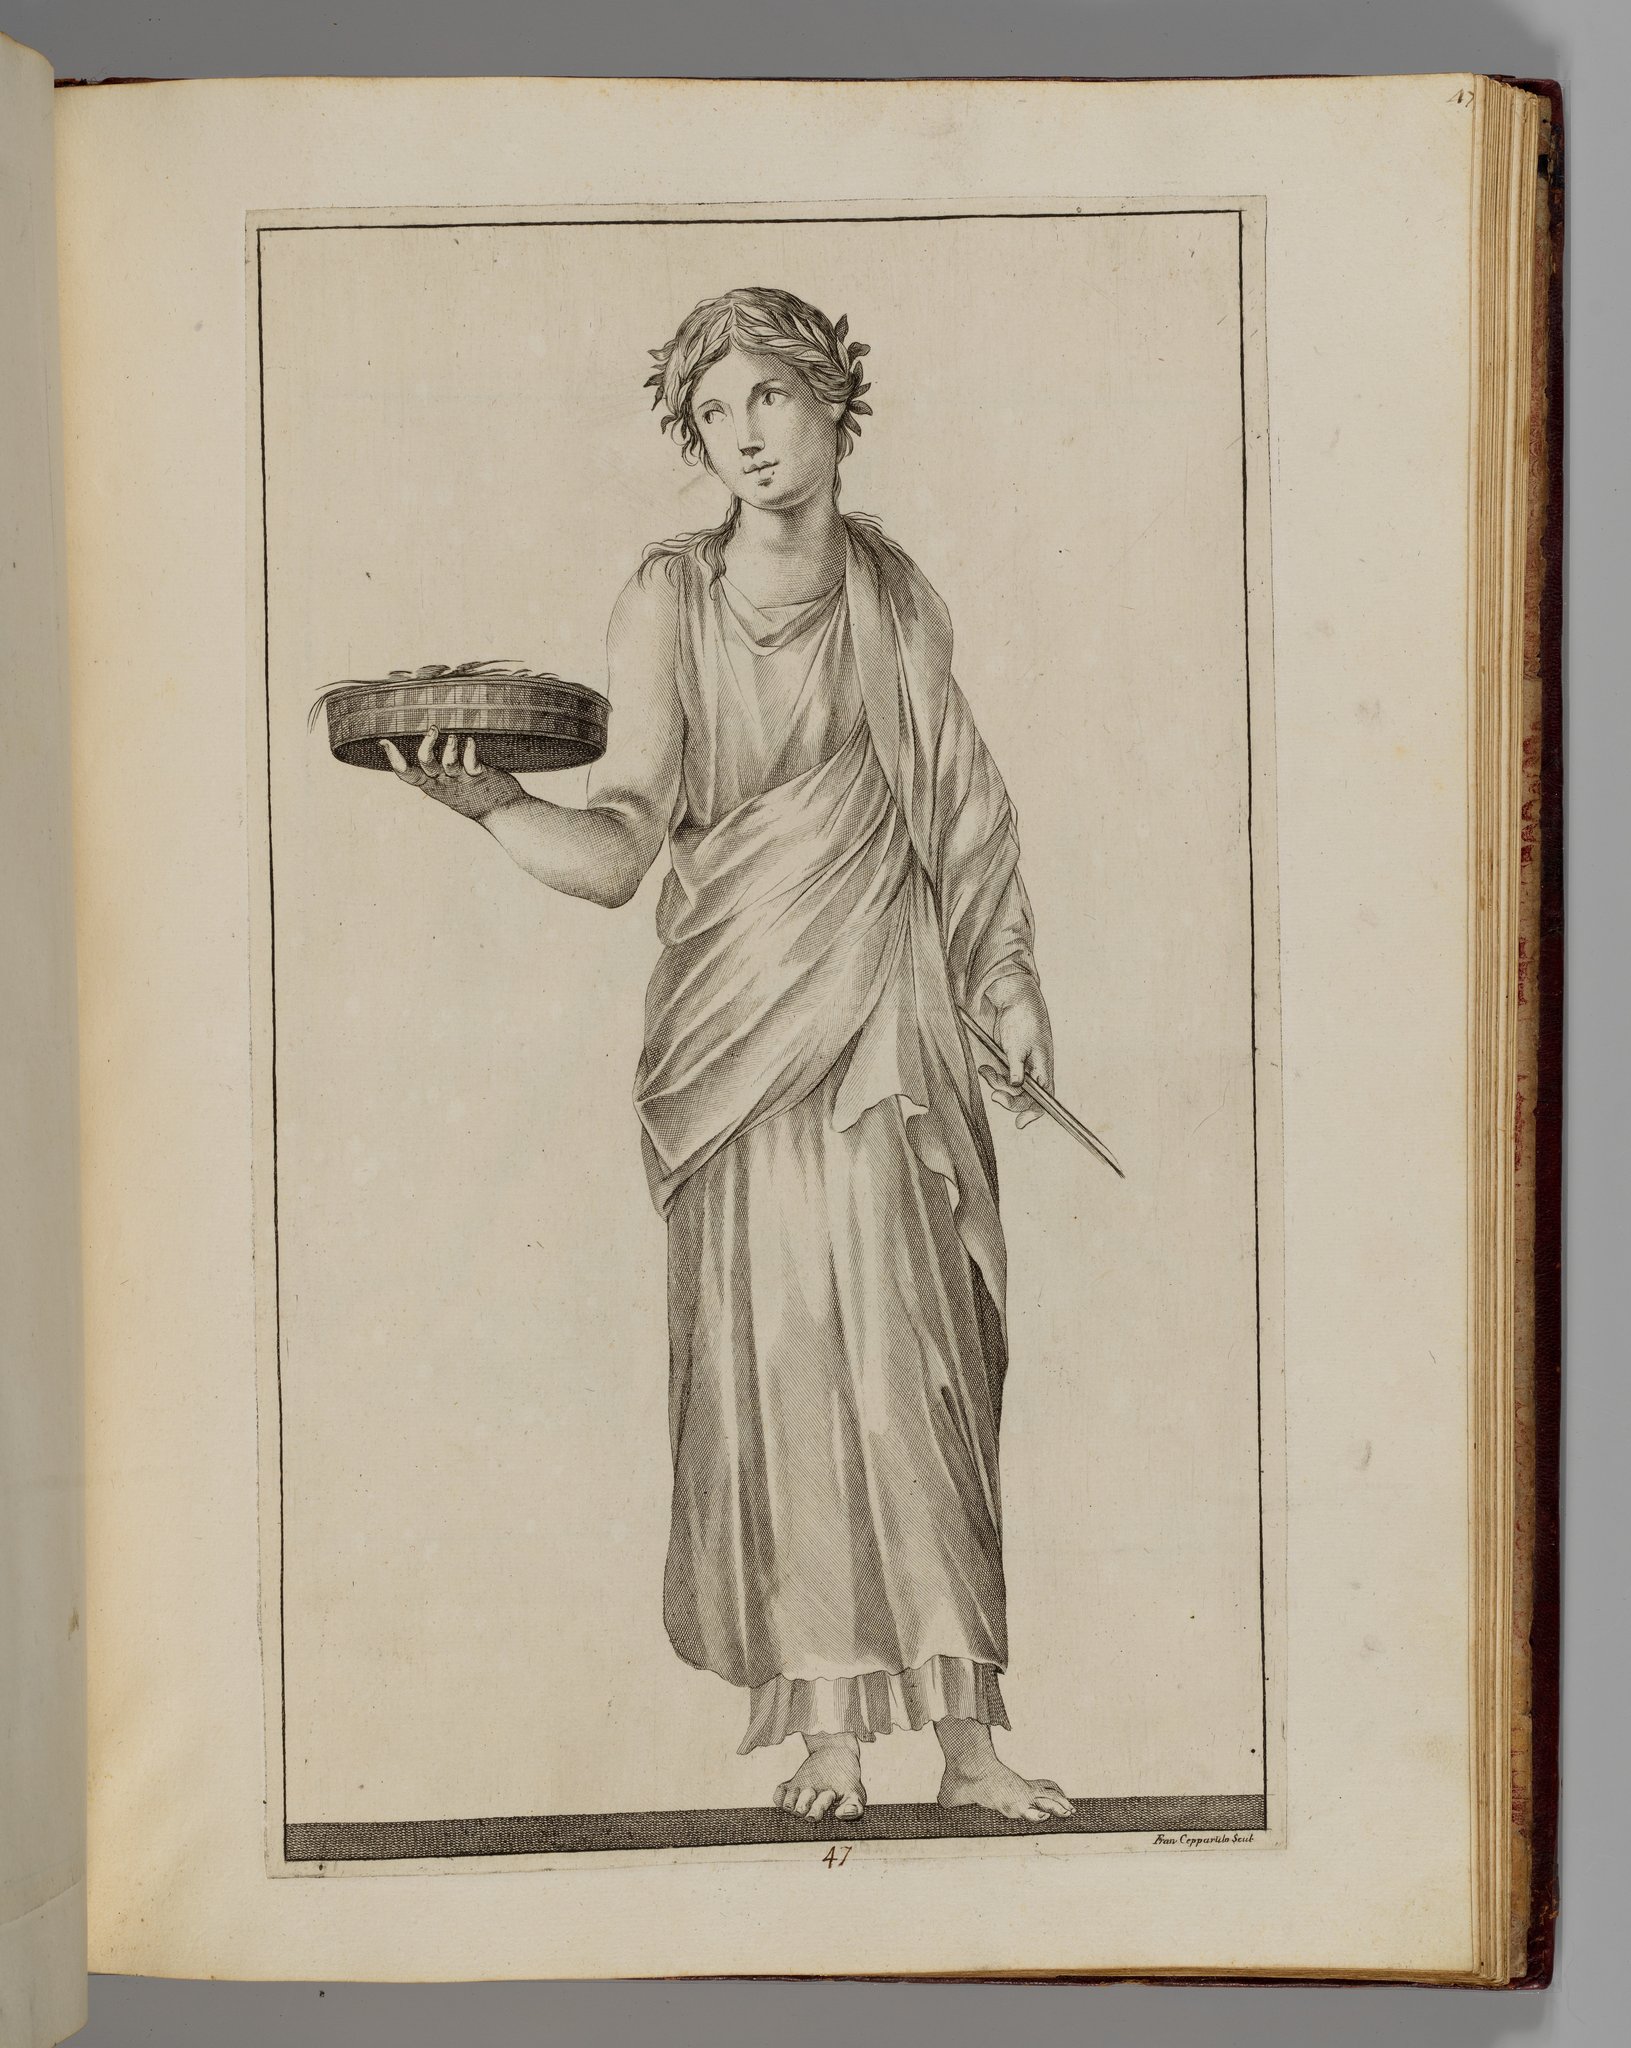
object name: book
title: Disegni intagliati in rame di pitture antiche ritrovate nelle scavazioni di Resina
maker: francesco sesoni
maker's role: artist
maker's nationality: italian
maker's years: 1704-1733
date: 1746